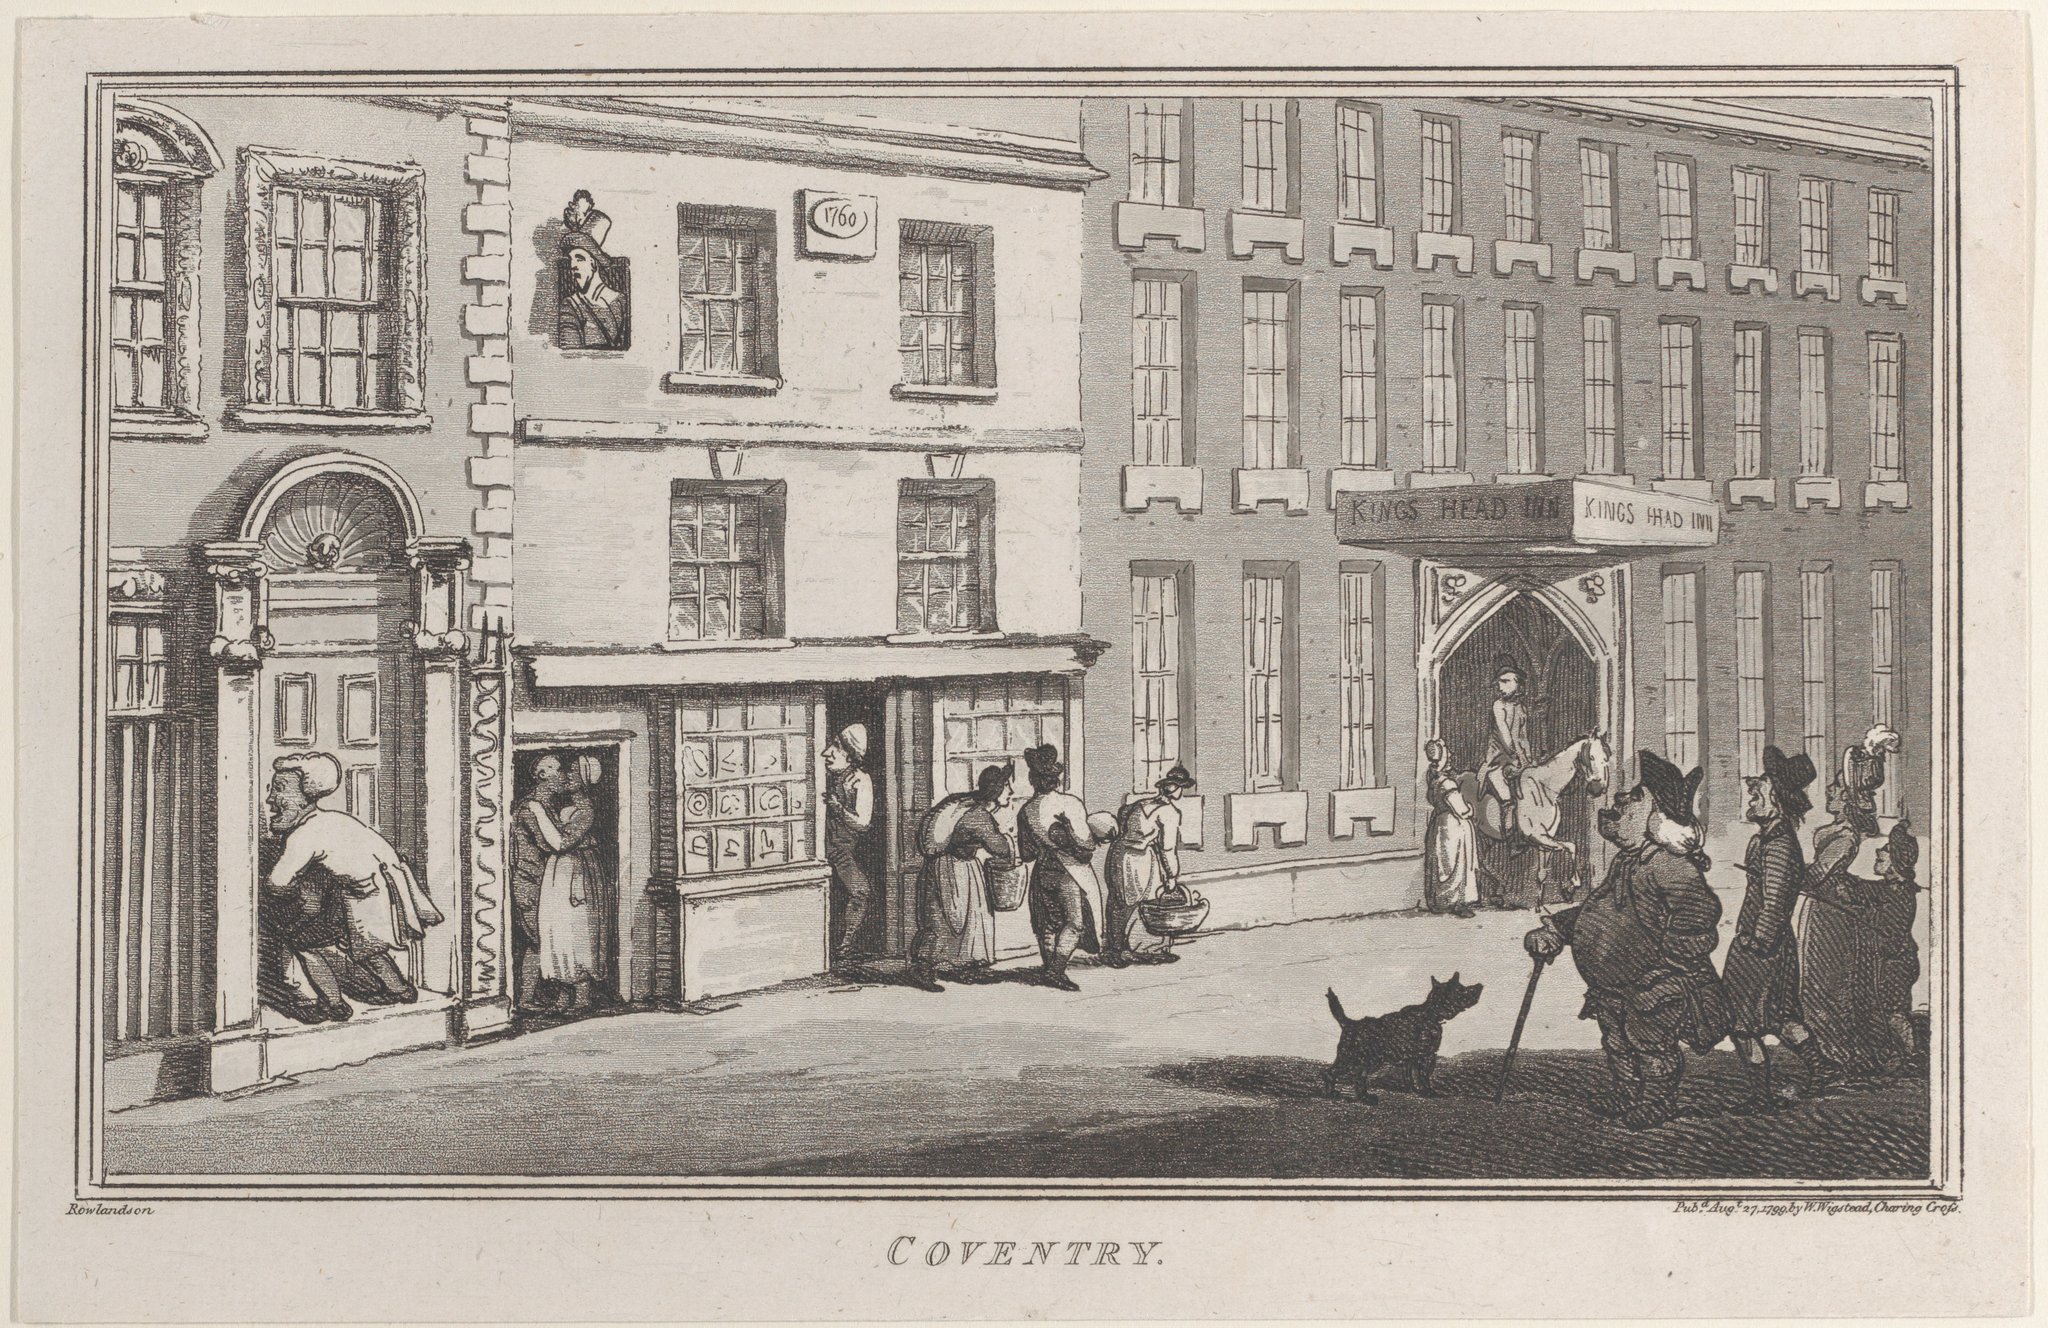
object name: print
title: Coventry, from "Remarks on a Tour to North and South Wales, in the year 1797"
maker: john hill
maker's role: artist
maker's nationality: british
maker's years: 1714-1775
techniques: aquatint, etching